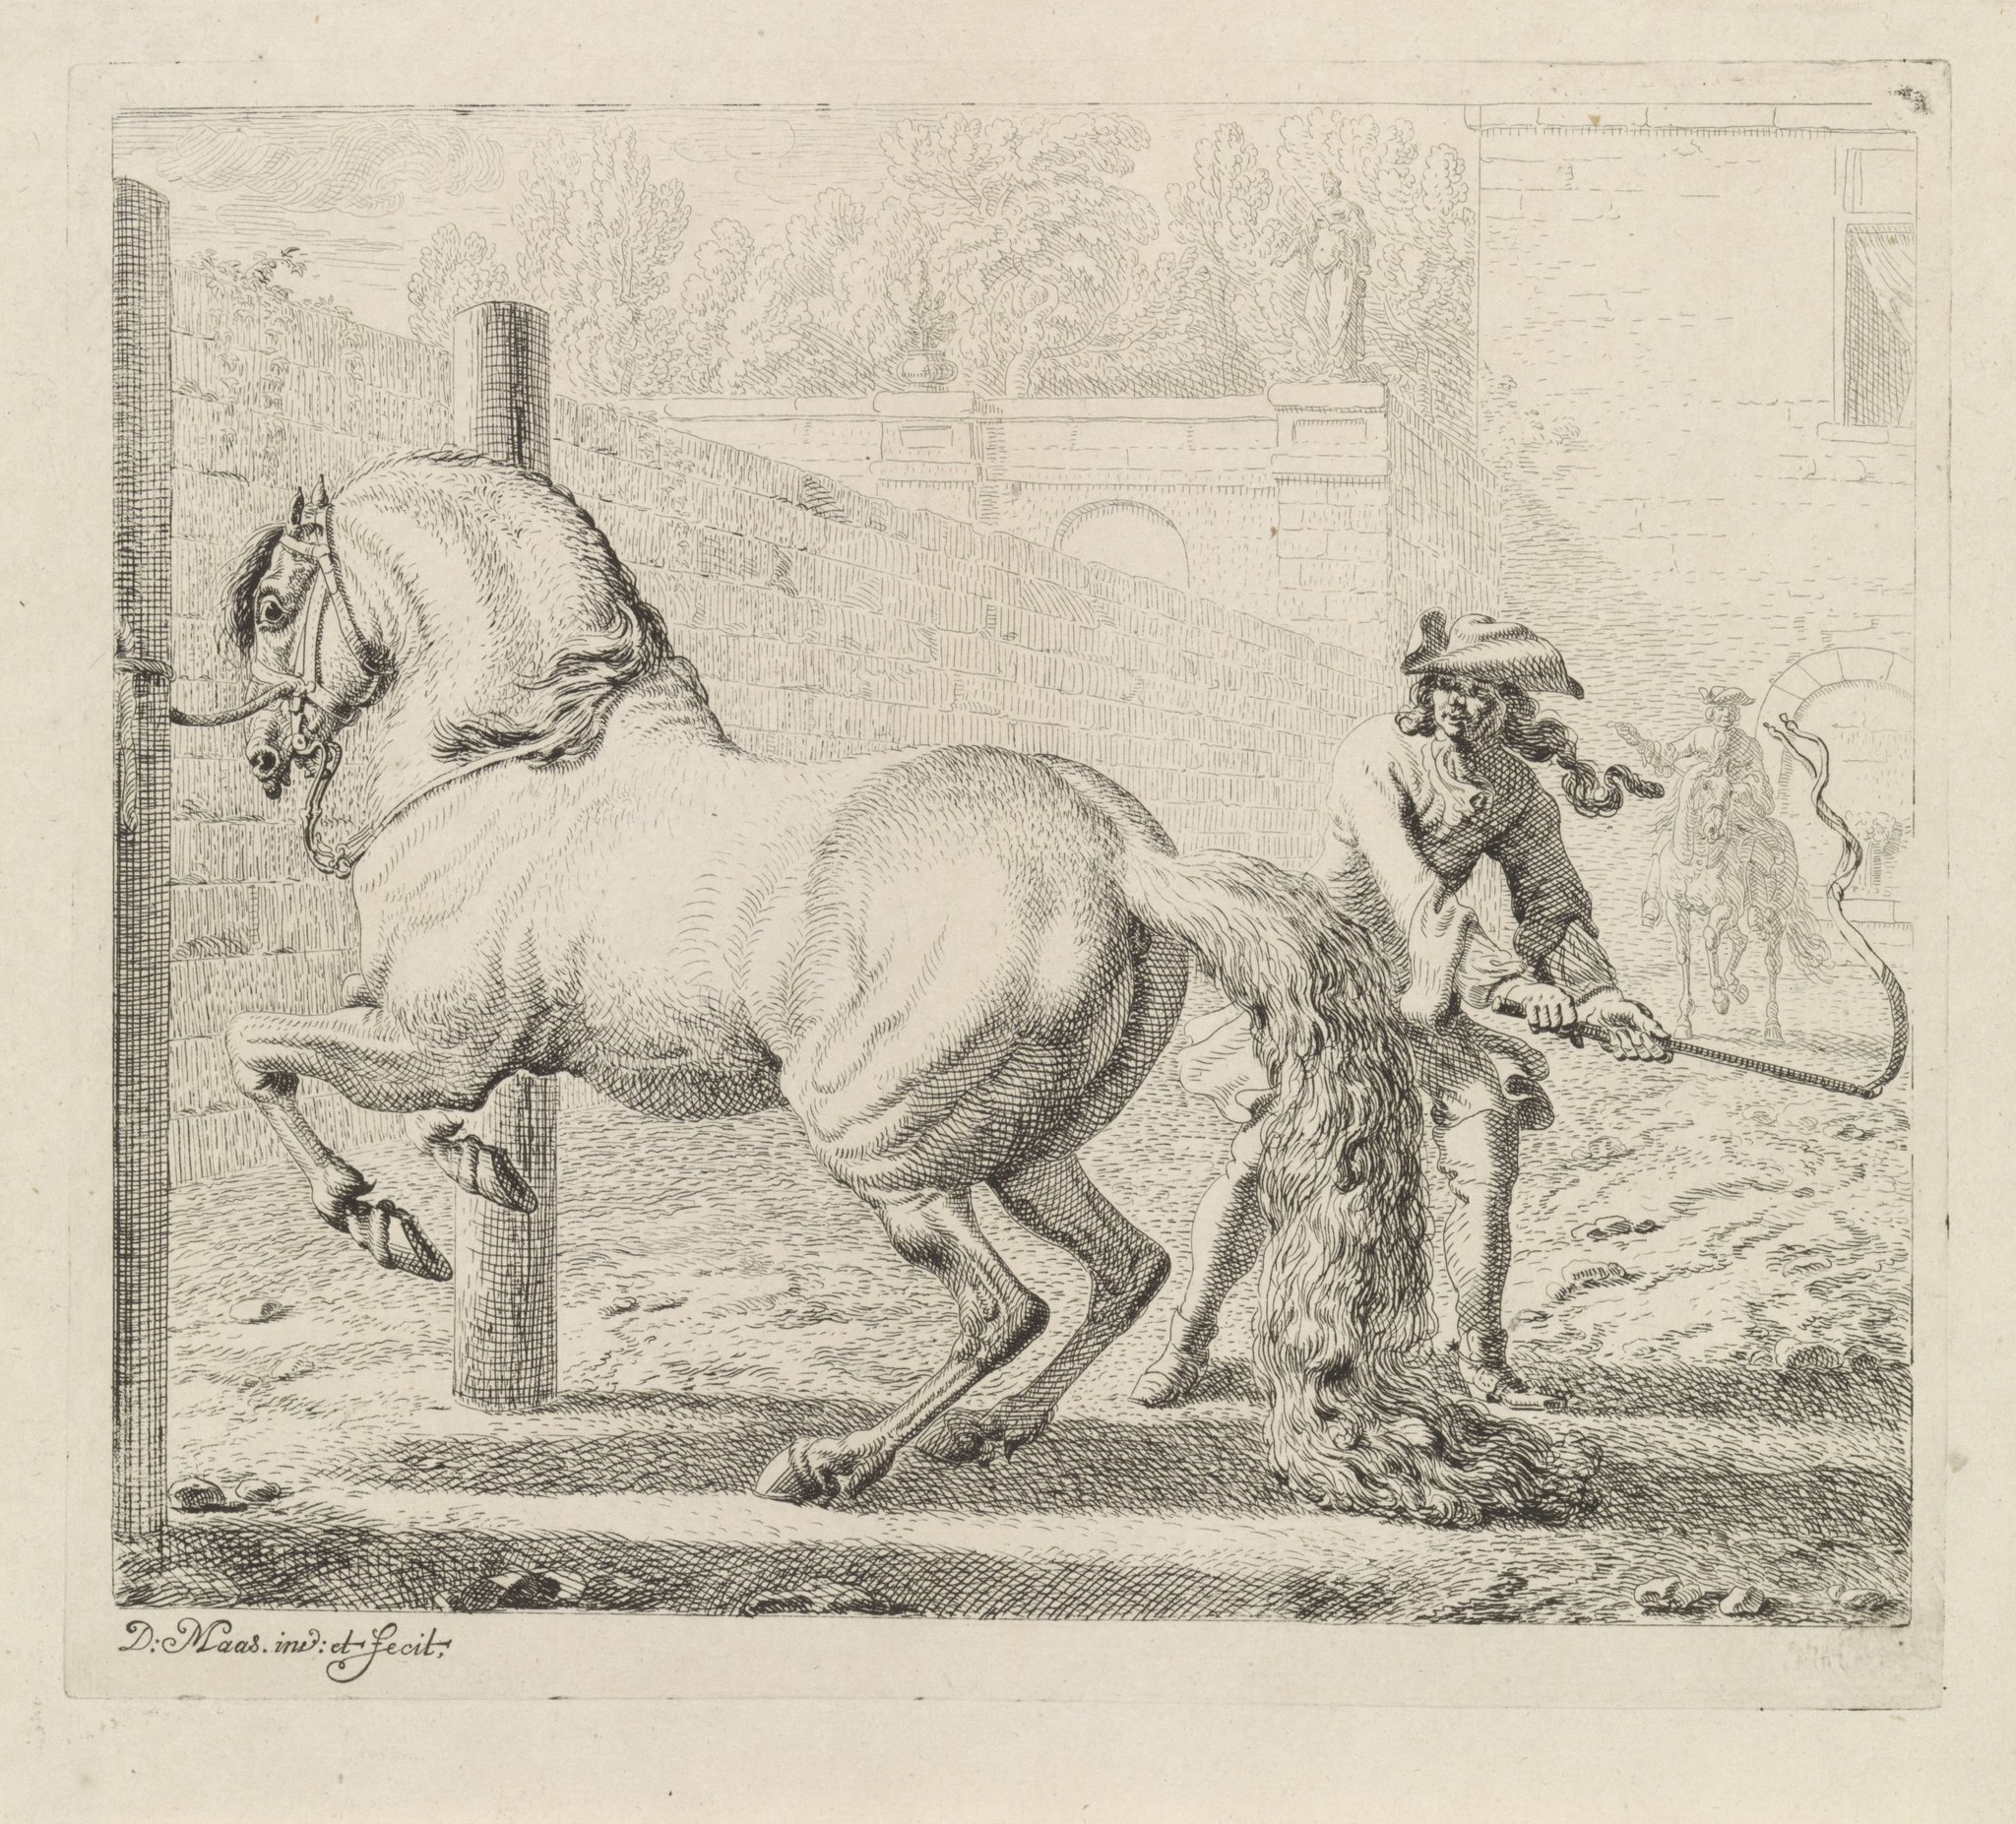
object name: print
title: Man met zweep bij een paard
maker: dirk maas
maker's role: draughtsman, print maker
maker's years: 1659-1717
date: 1669-1717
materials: paper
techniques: etching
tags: training of horses, horse, riding-school, manège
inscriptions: collector's mark: Lugt 240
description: Man met een zweep bij een paard dat is vastgebonden aan een paal, op een binnenplaats. Prent uit een serie van negen prenten met onderwerp de manege.